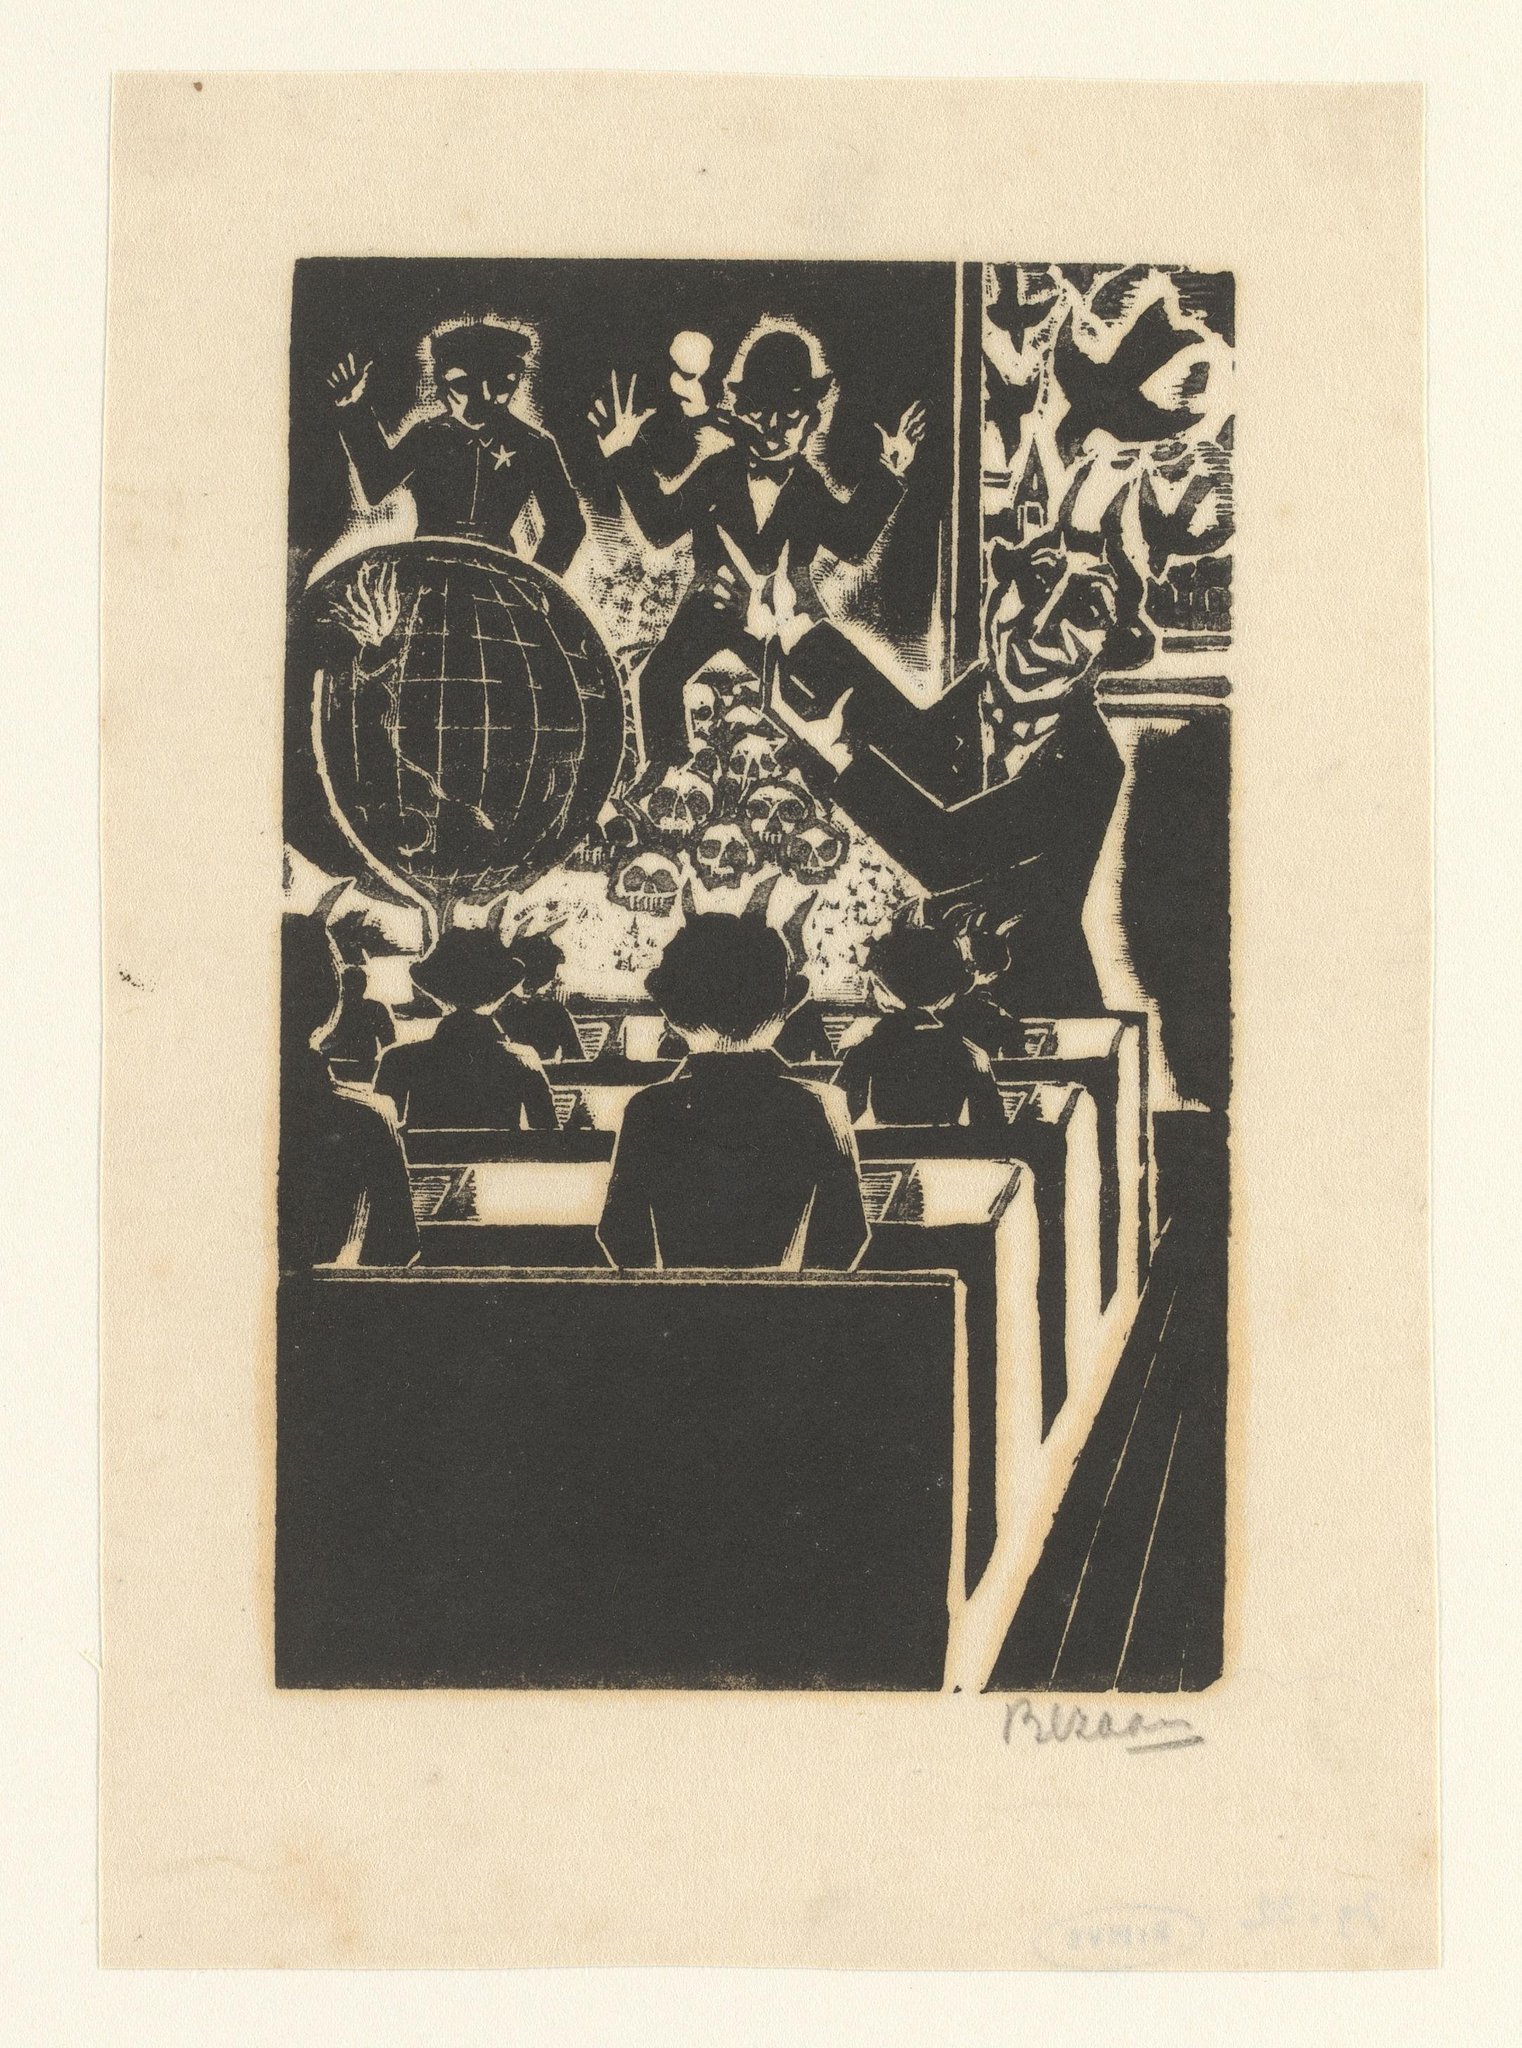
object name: print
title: Duivelsschool II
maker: jo bezaan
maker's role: draughtsman, print maker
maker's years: 1894-1952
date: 1946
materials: paper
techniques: woodcut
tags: teacher and pupil, human-shaped devil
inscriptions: collector's mark: Lugt 2228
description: Deze prent werd gemaakt als illustratie bij 'Het boek van Marc' door Jac. van Hattum. Dit werk is echter nooit als zodanig uitgegeven.